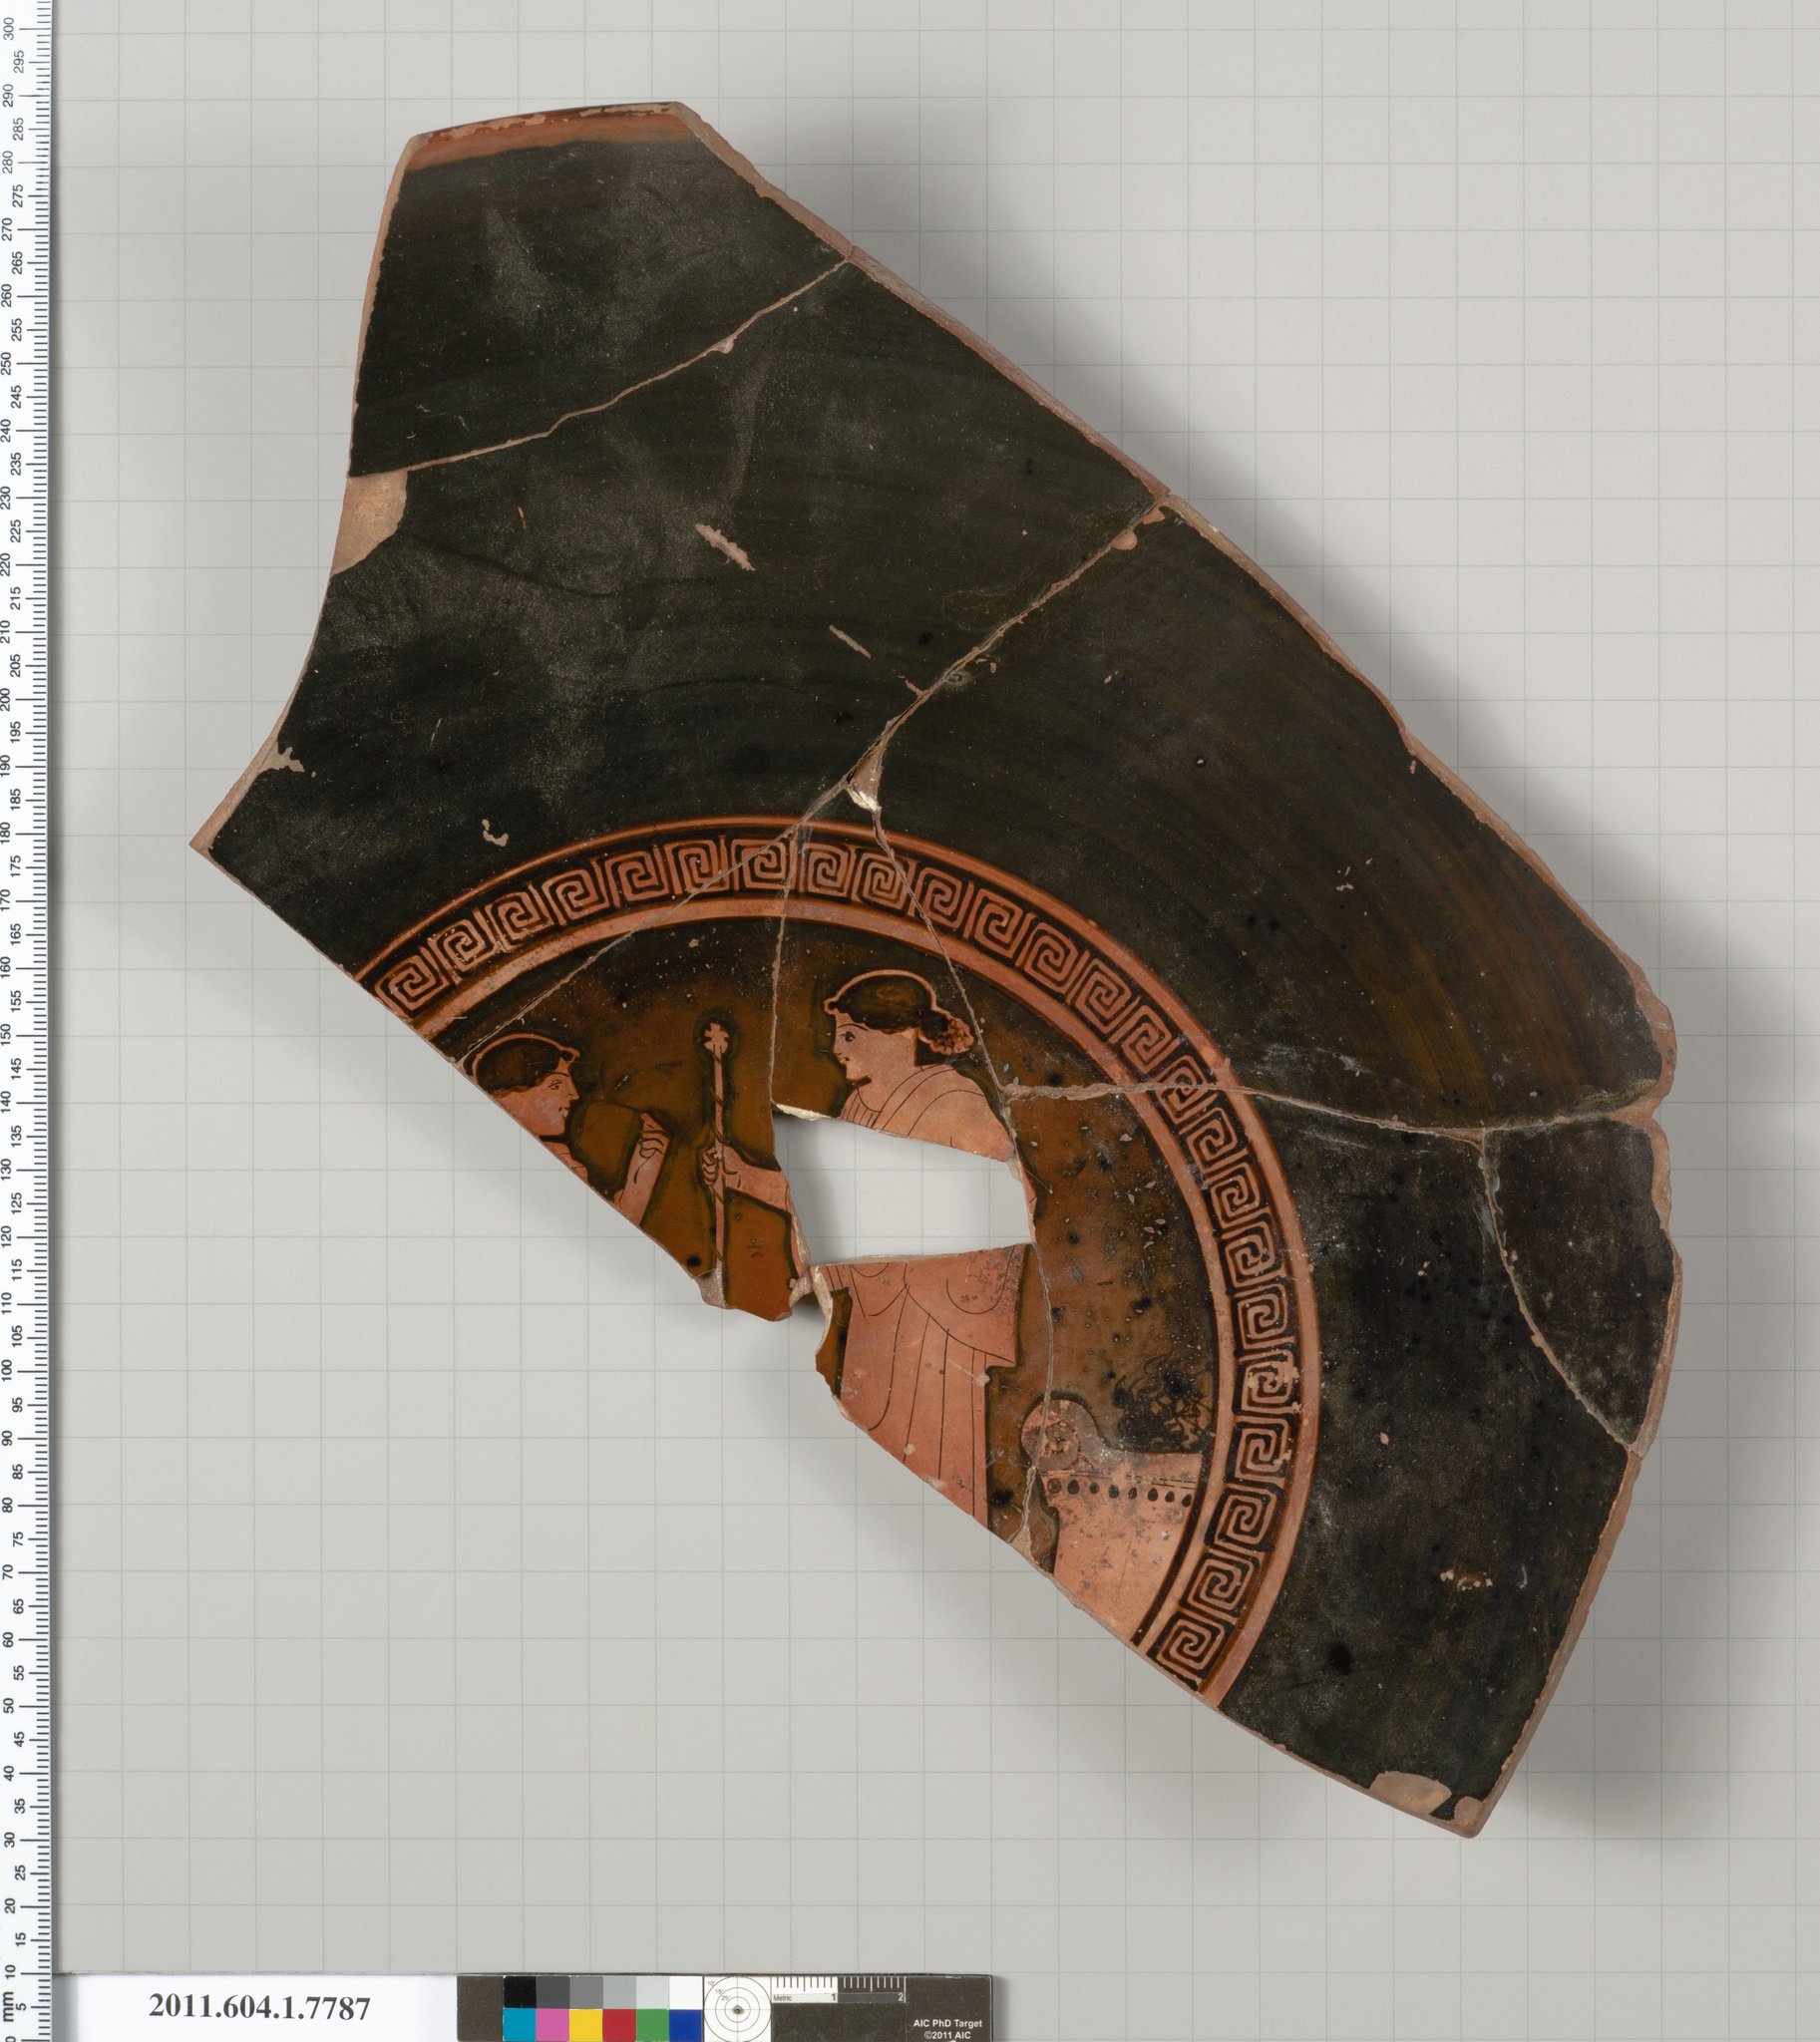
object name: kylix fragment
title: Terracotta fragment of a kylix (drinking cup)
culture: greek, attic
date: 460-450 BCE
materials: terracotta